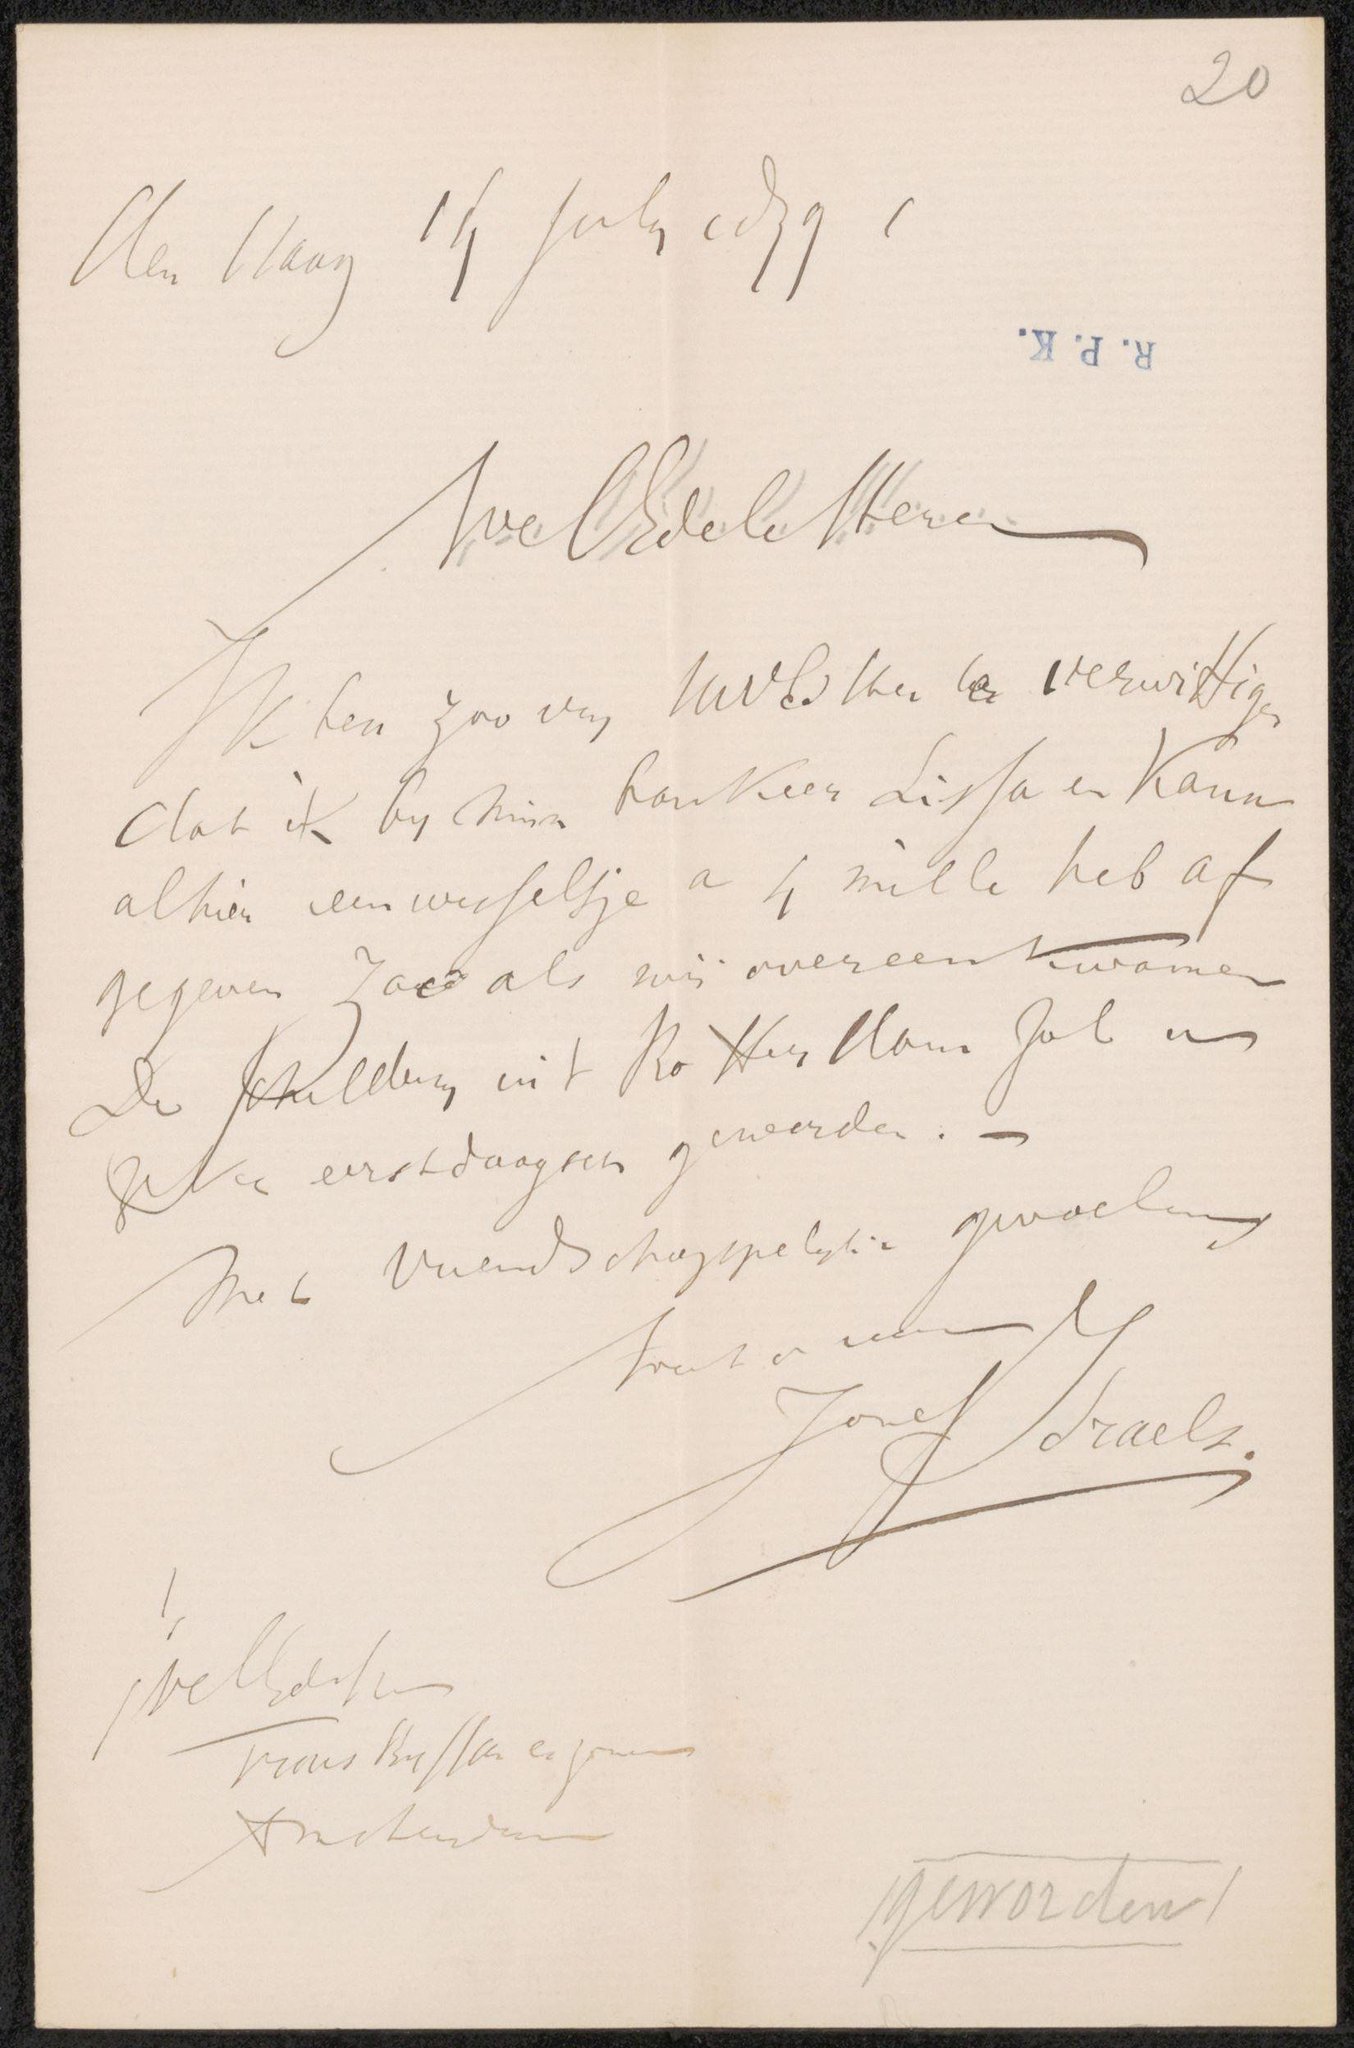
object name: letter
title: Brief aan Frans Buffa en Zonen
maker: jozef israëls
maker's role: draughtsman, painter, print maker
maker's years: 1824-1911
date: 1879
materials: ink, paper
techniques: pen, writing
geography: the hague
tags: publisher, painting (including book-illumination, miniature-painting), money, rotterdam, amsterdam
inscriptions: collector's mark: Lugt 2233